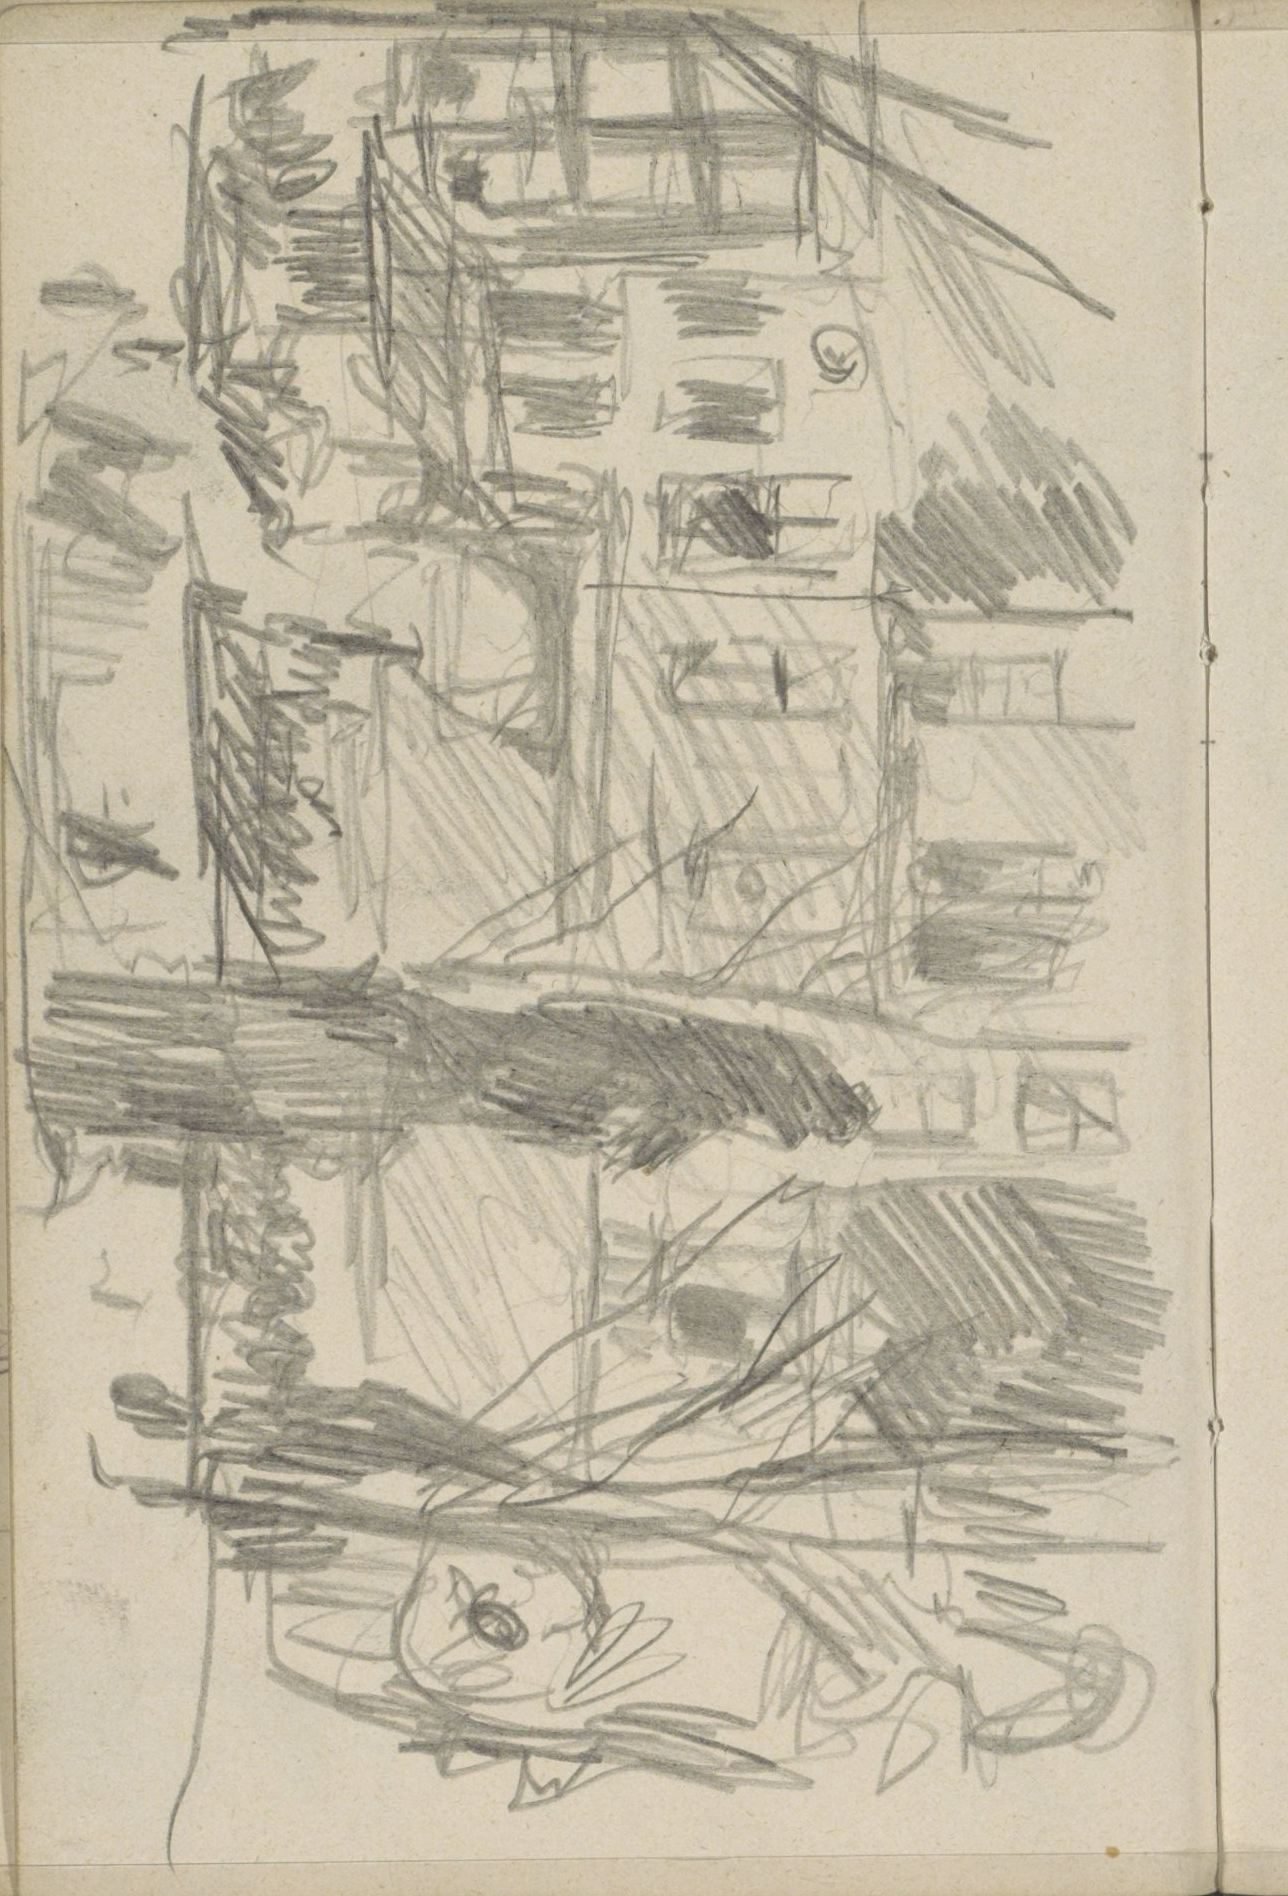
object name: sketchbook leaf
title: Gezicht op gebouwen, mogelijk op de Dam te Amsterdam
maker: george hendrik breitner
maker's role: draughtsman, painter, print maker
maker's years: 1857-1923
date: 1914-1923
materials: paper, pencil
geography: amsterdam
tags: urban housing, city-view, and landscape with man-made constructions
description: Gezicht op gebouwen met luifels, mogelijk op de Dam te Amsterdam. Vooraan een standbeeld, mogelijk het Monument 1830 ('Naatje'). Pagina 53 uit een schetsboek met 43 bladen vervaardigd te Amsterdam.